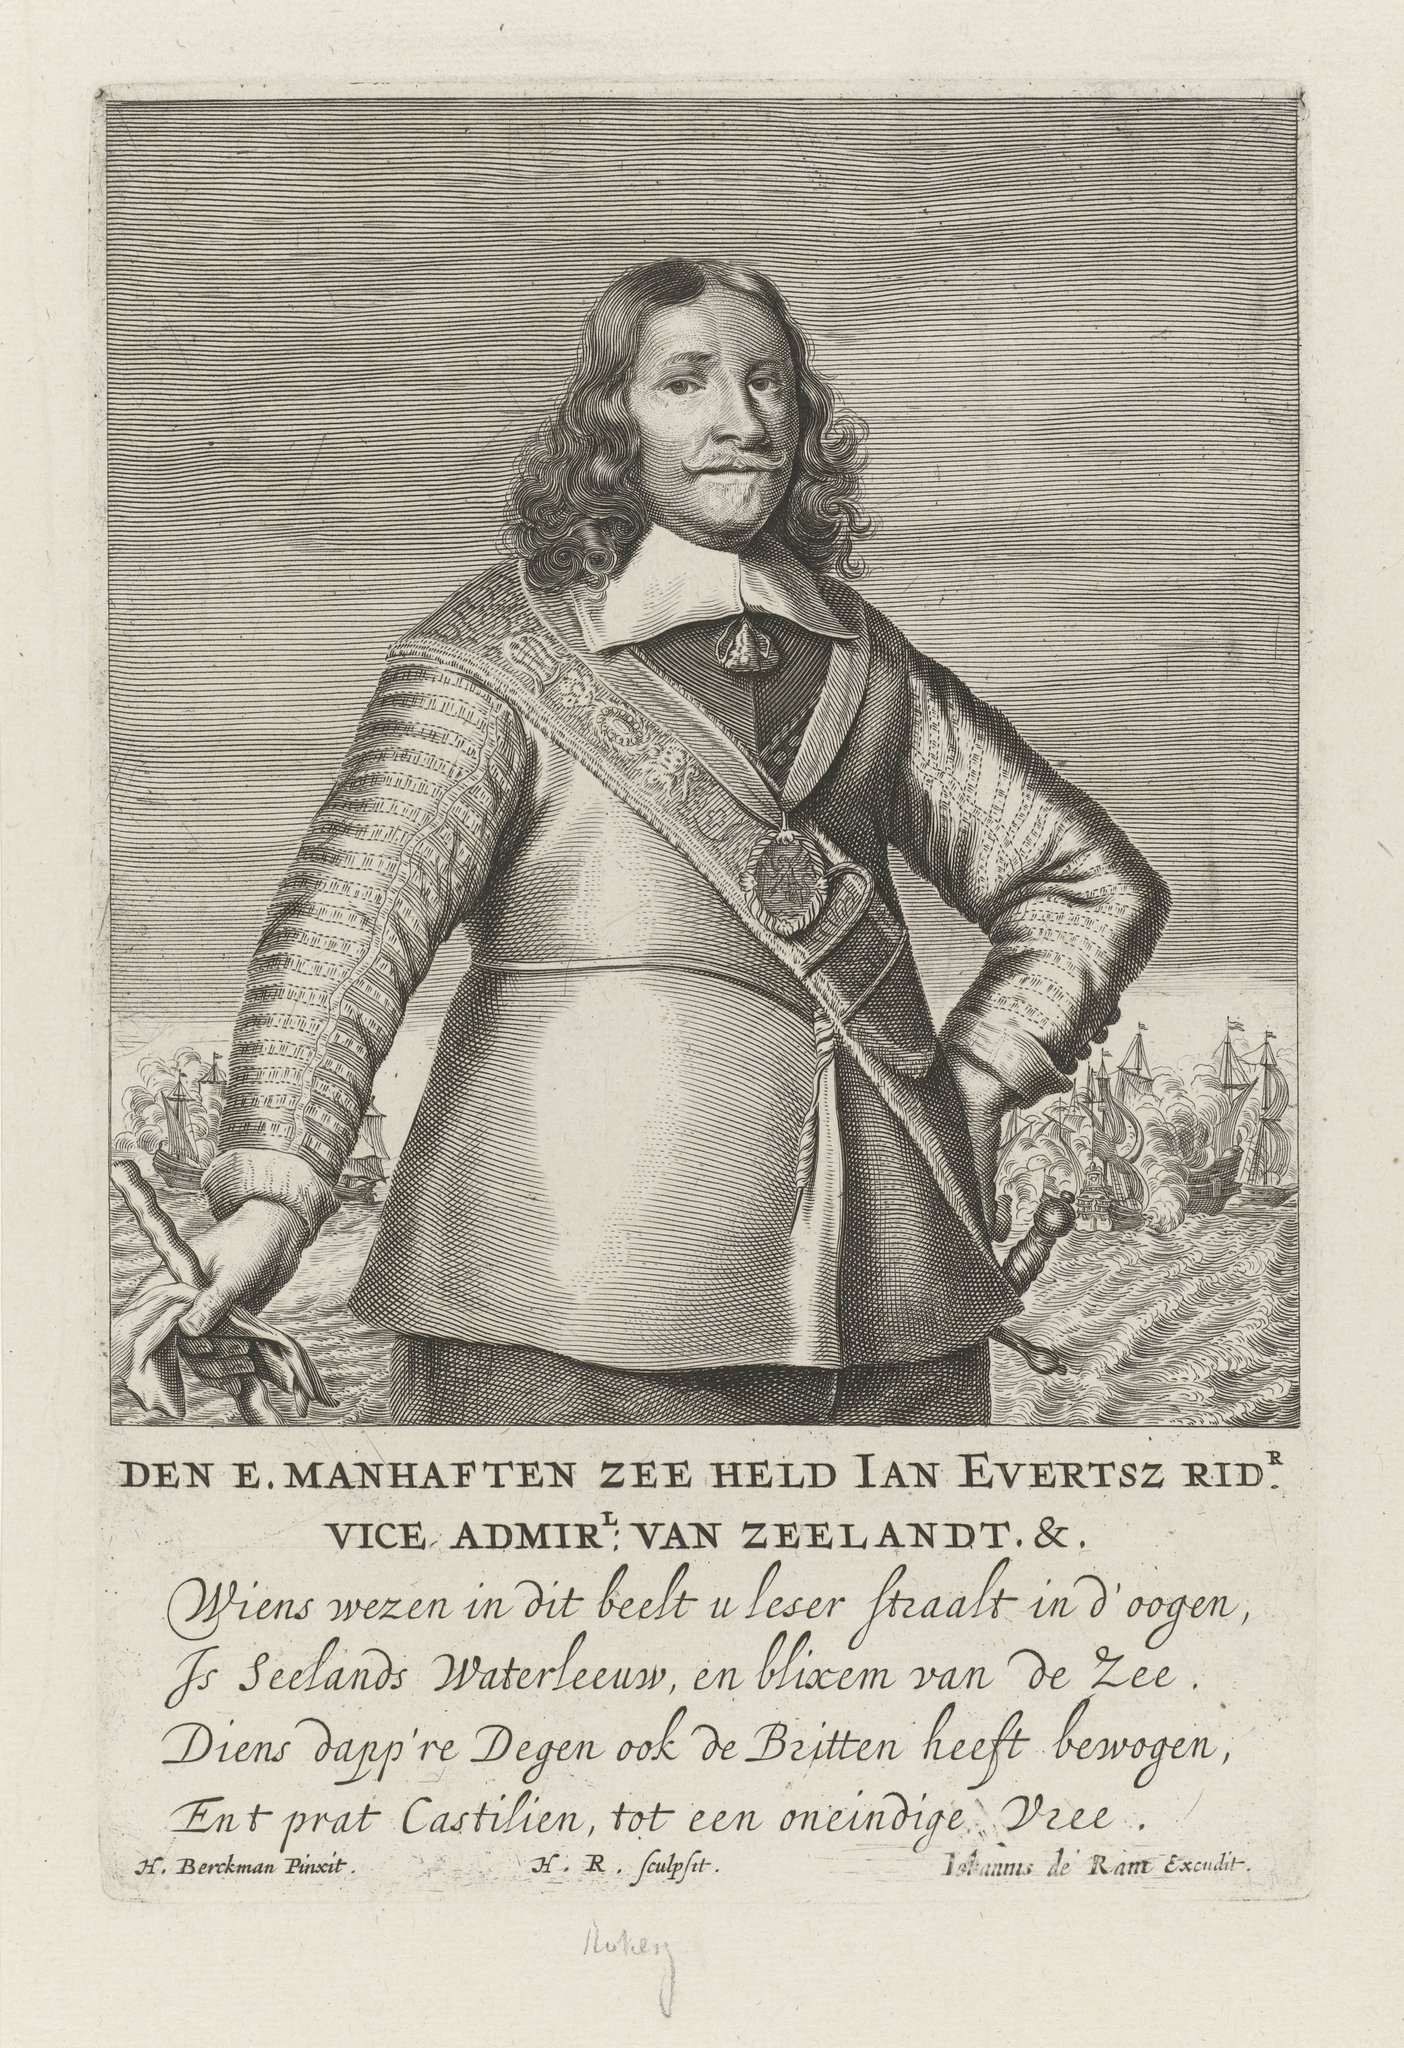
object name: print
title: Portret van Johan Evertsen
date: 1658-1693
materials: paper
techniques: engraving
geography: northern netherlands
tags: flushing, warfare; military affairs (+ sailing-ships), battle, fighting in general (+ naval force)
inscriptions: collector's mark: Lugt 240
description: Portret van Cornelis Evertsen, admiraal van Zeeland. Hij draagt een medaillon met een engel die een draak doodt. Op de achtergrond een zeeslag. In de marge zijn naam, titel en een lofdicht.